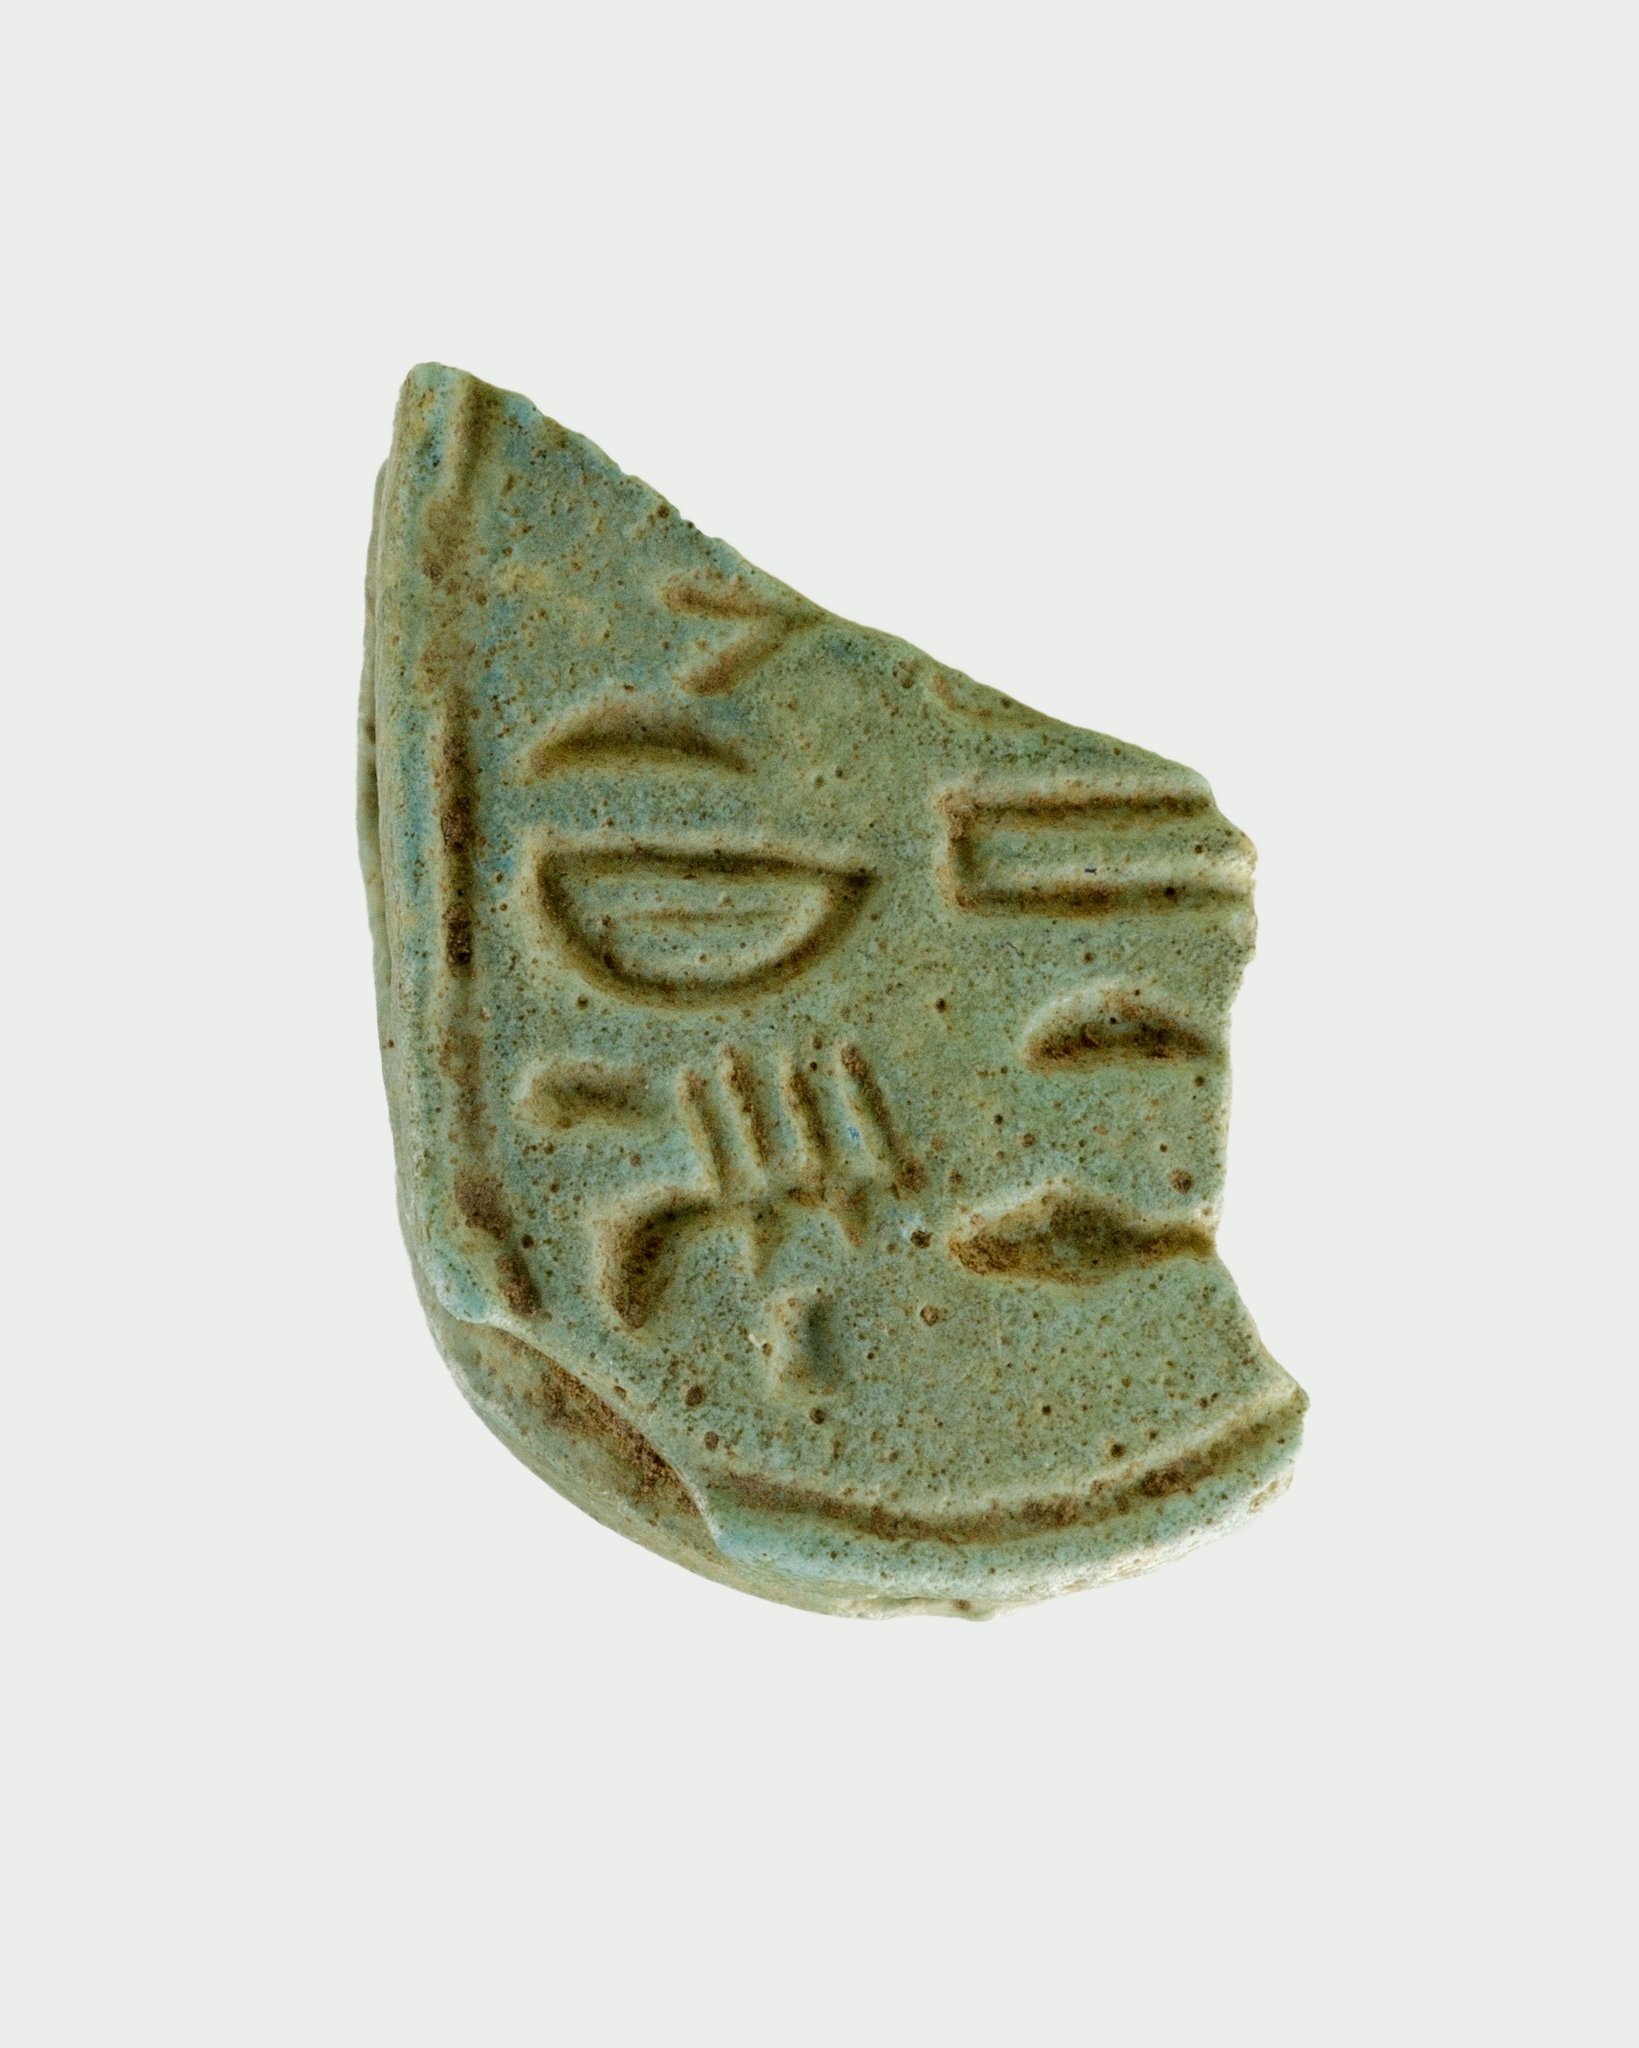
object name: scarab, official, private name and title, funerary epithet, ay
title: Fragment of a Scarab of a Lady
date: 1850-1640 BCE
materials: faience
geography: egypt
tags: hieroglyphs,scarabs